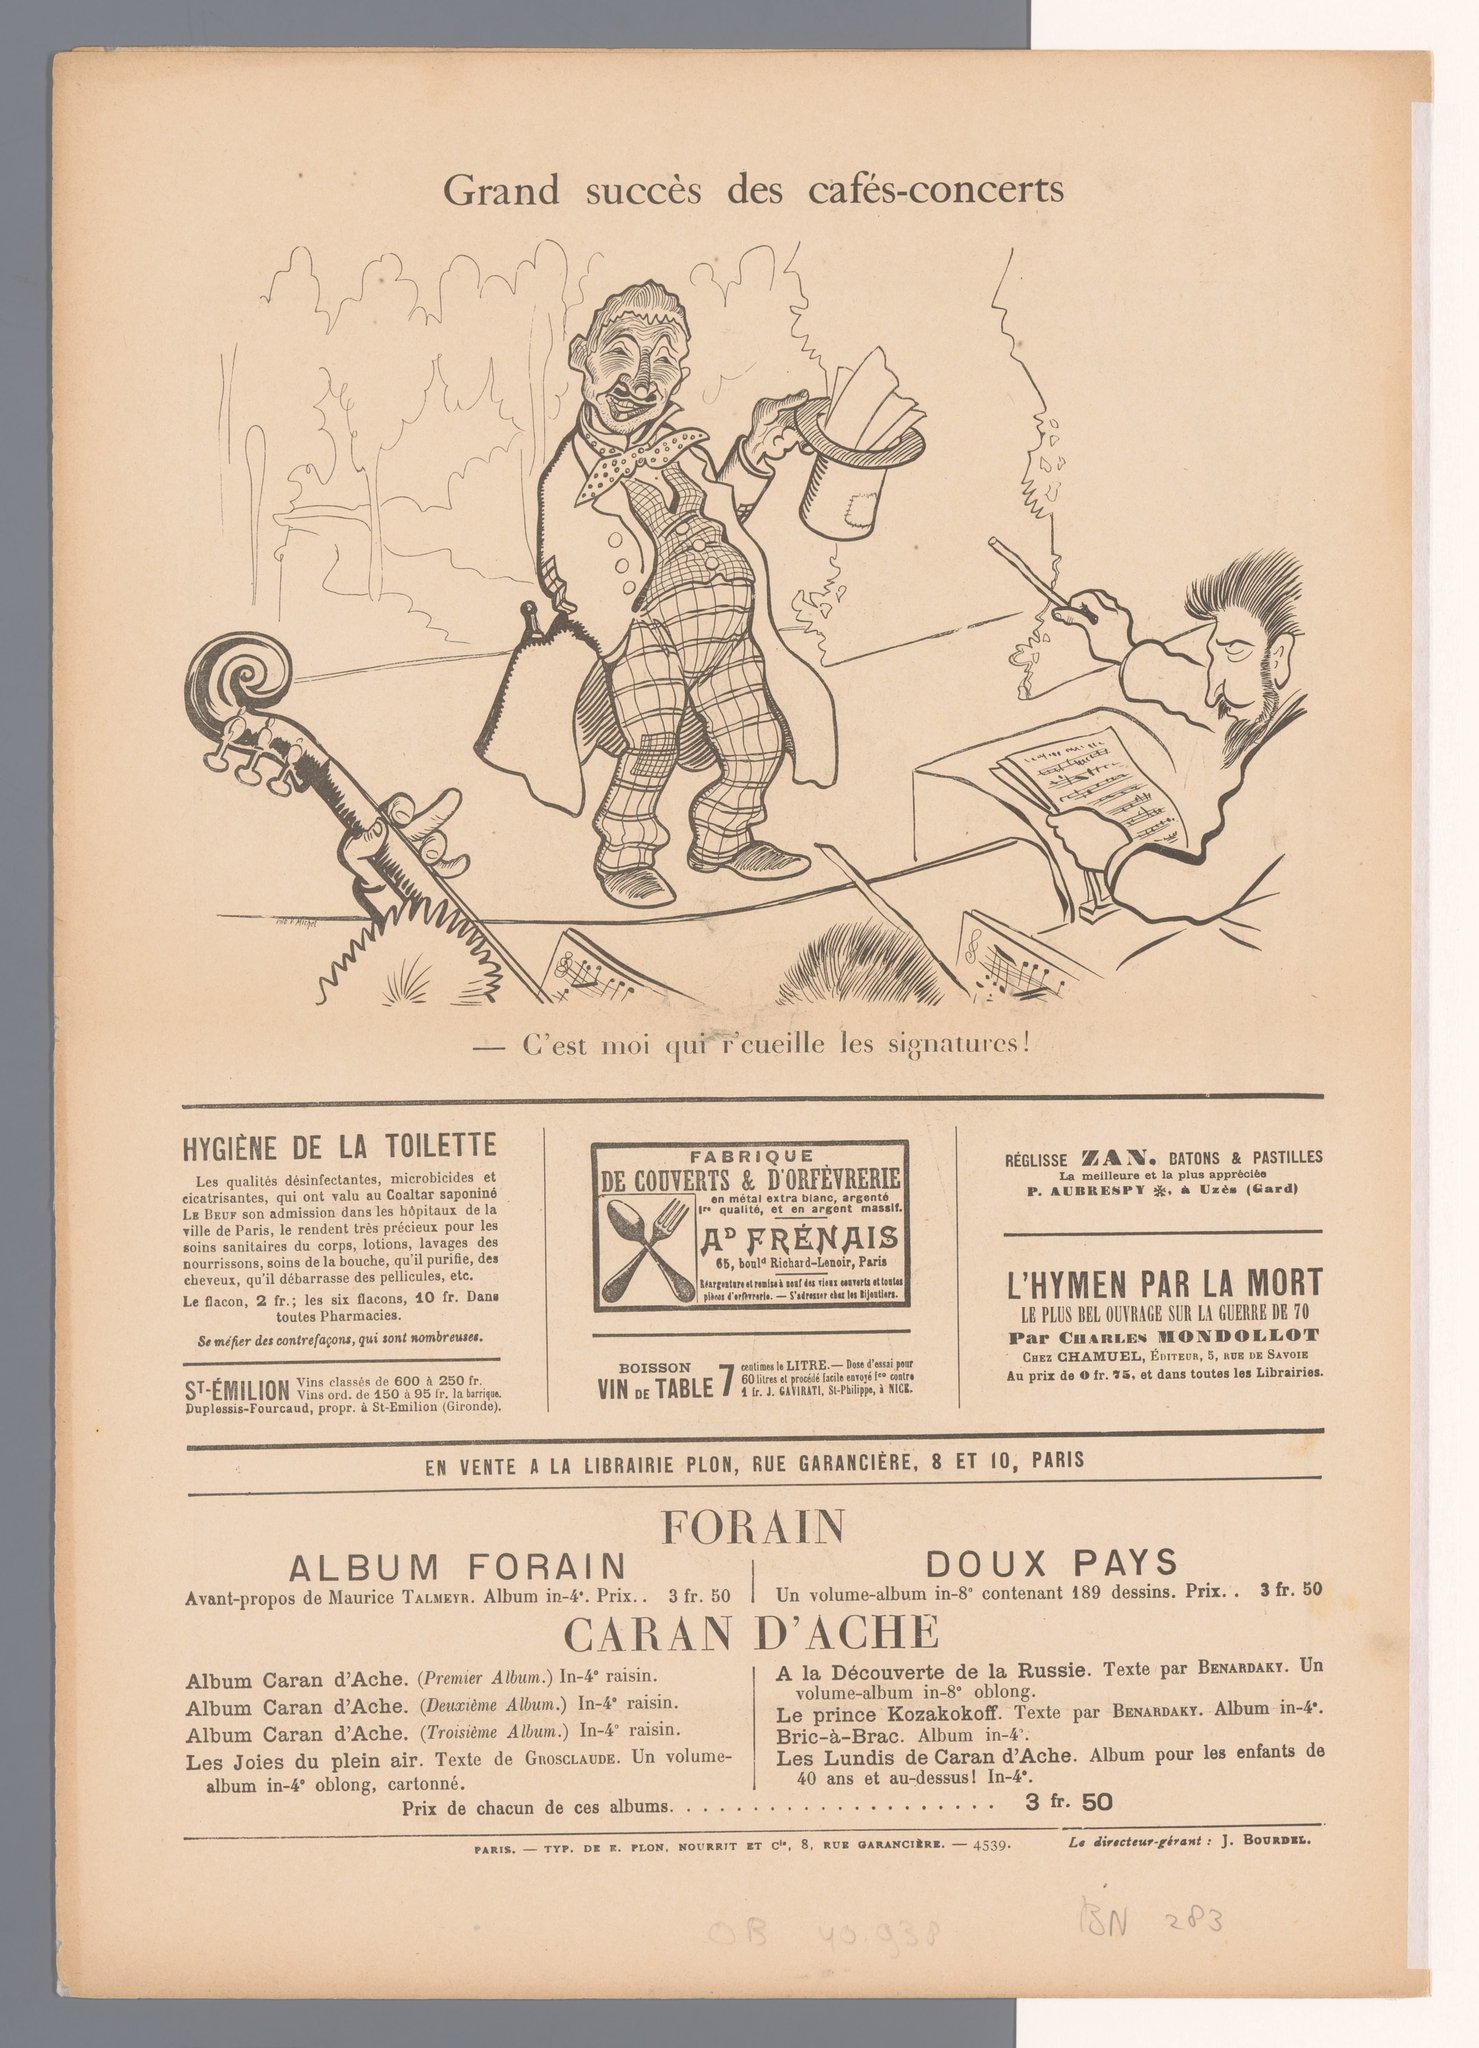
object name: leaflet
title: Grand succès des cafés-concerts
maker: v. michel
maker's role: print maker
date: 1898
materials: paper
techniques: lithograph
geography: paris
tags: caricatures (human types), political caricatures and satires, the arts of the stage: ballet, theatre, musical drama, motion picture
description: Prent gebruikt voor: Psst...!, nr. 45, 10 december 1898. Psst..! was een politieke weekkrant met antisemitische en anti-Dreyfus cartoons.